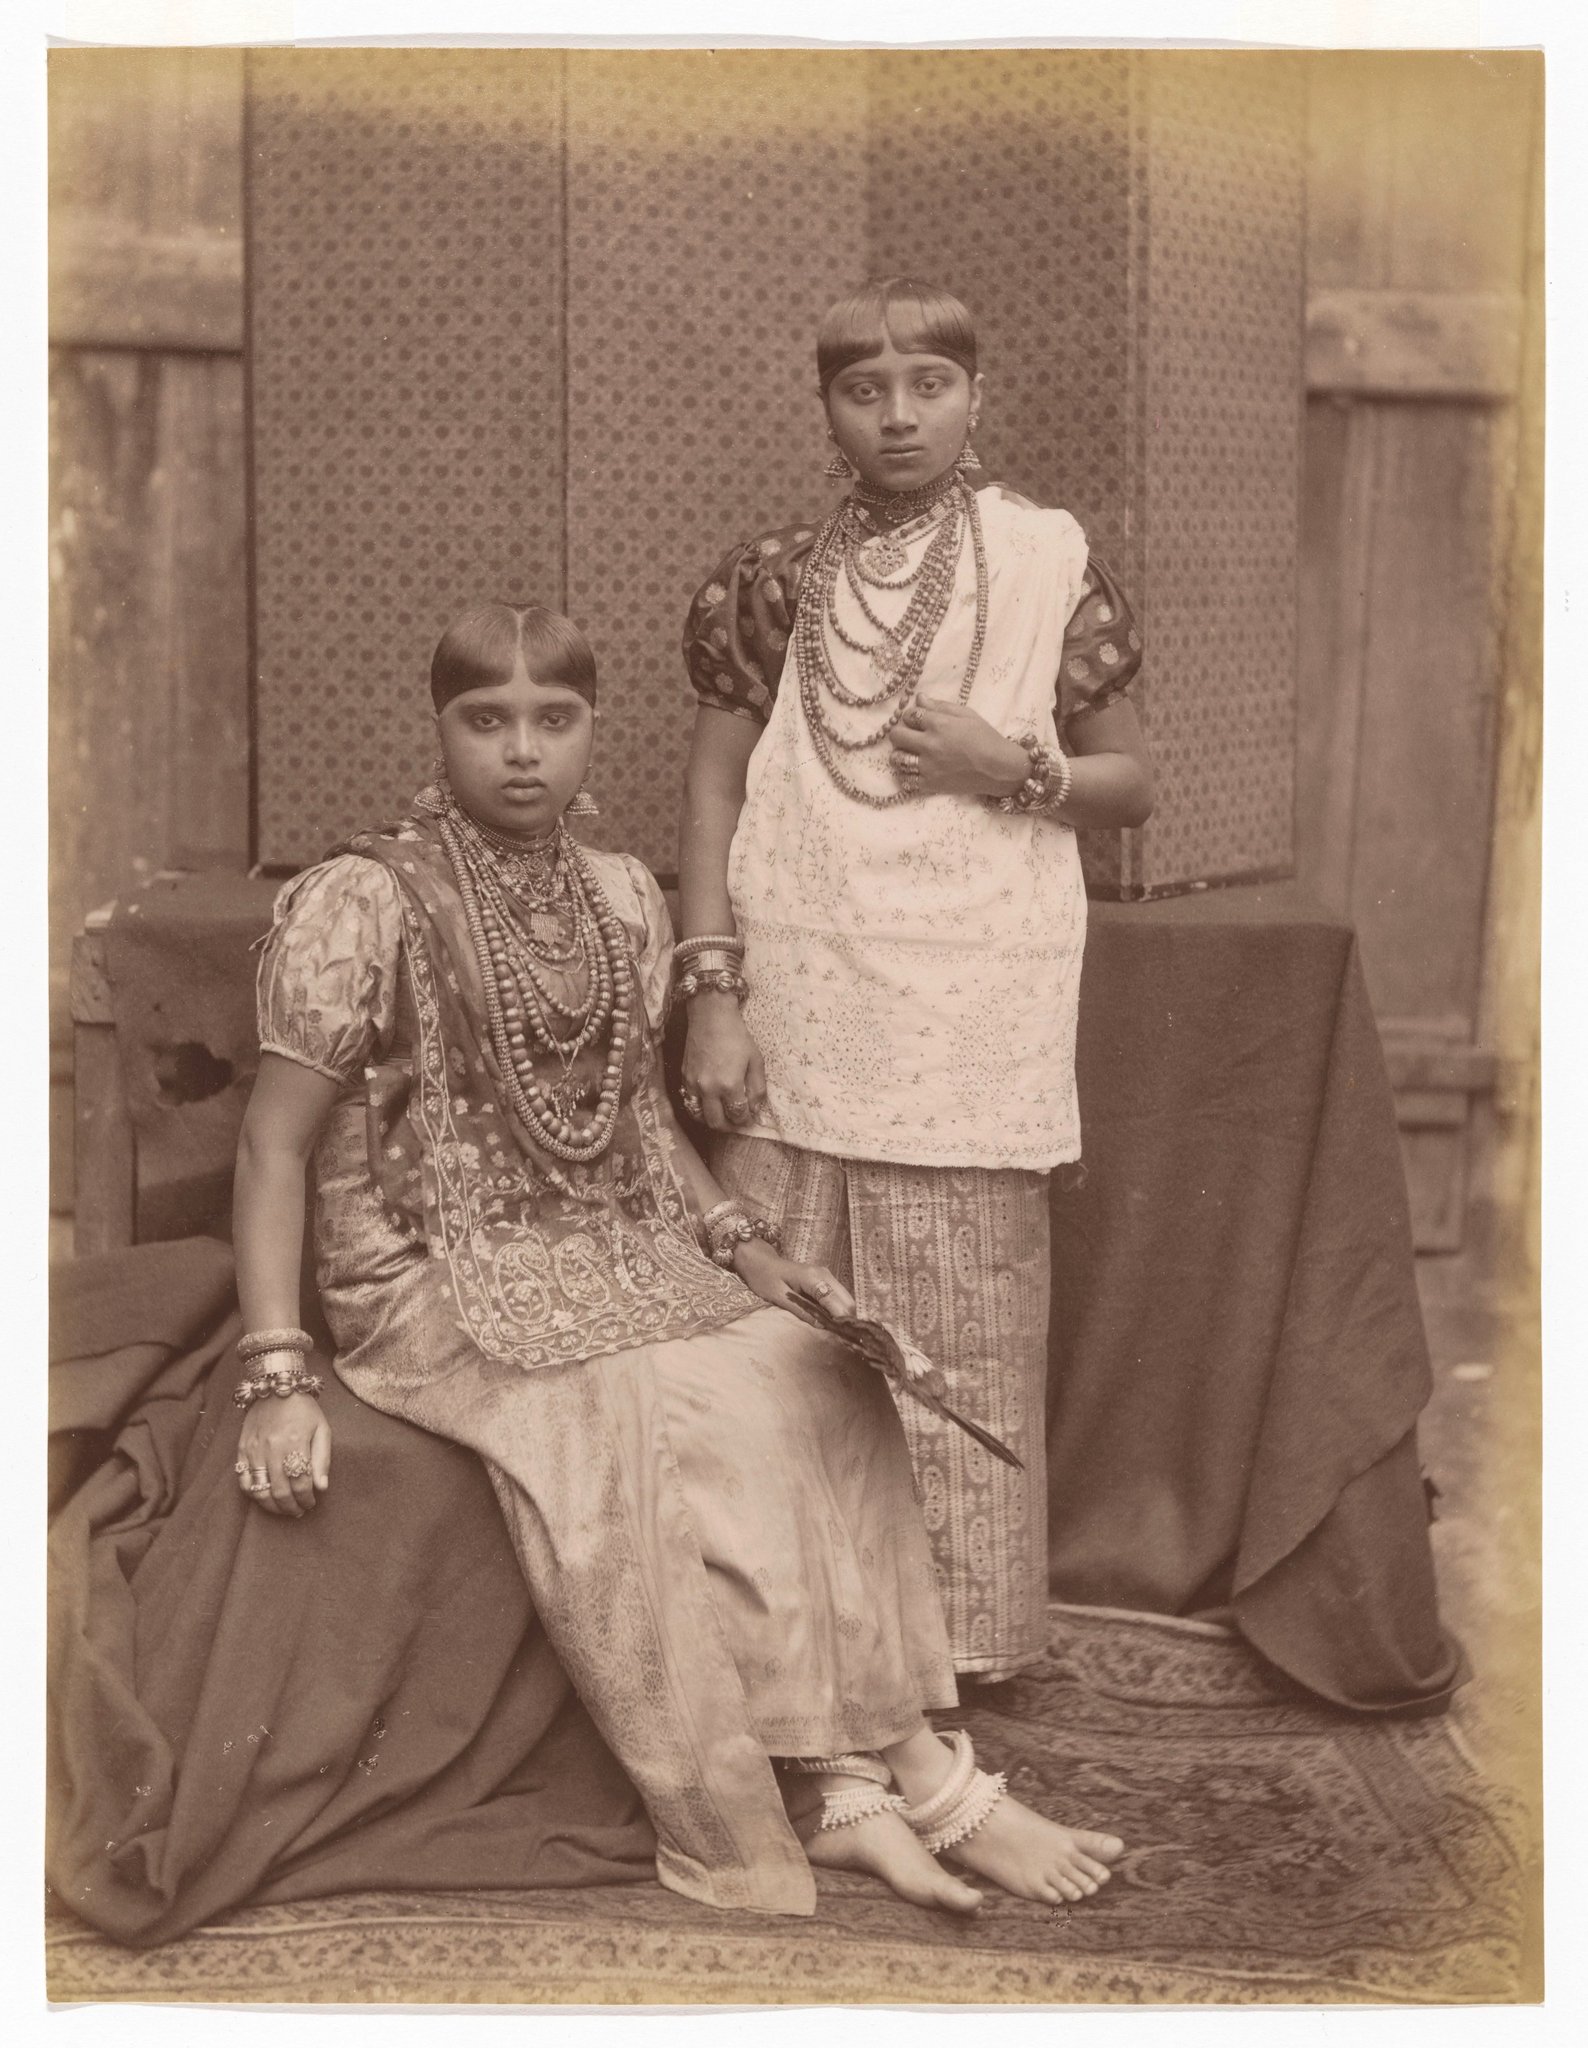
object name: photograph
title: Portrait of two unknown women from Kandy, dressed in traditional clothes, Sri Lanka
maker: Anonymous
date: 1876-1893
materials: paper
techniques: albumen print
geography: sri lanka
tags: adult woman, ornaments, jewels, anonymous historical person portrayed, sri lanka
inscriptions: inscription: ‘Kandyan Ladies’, number: ‘143’